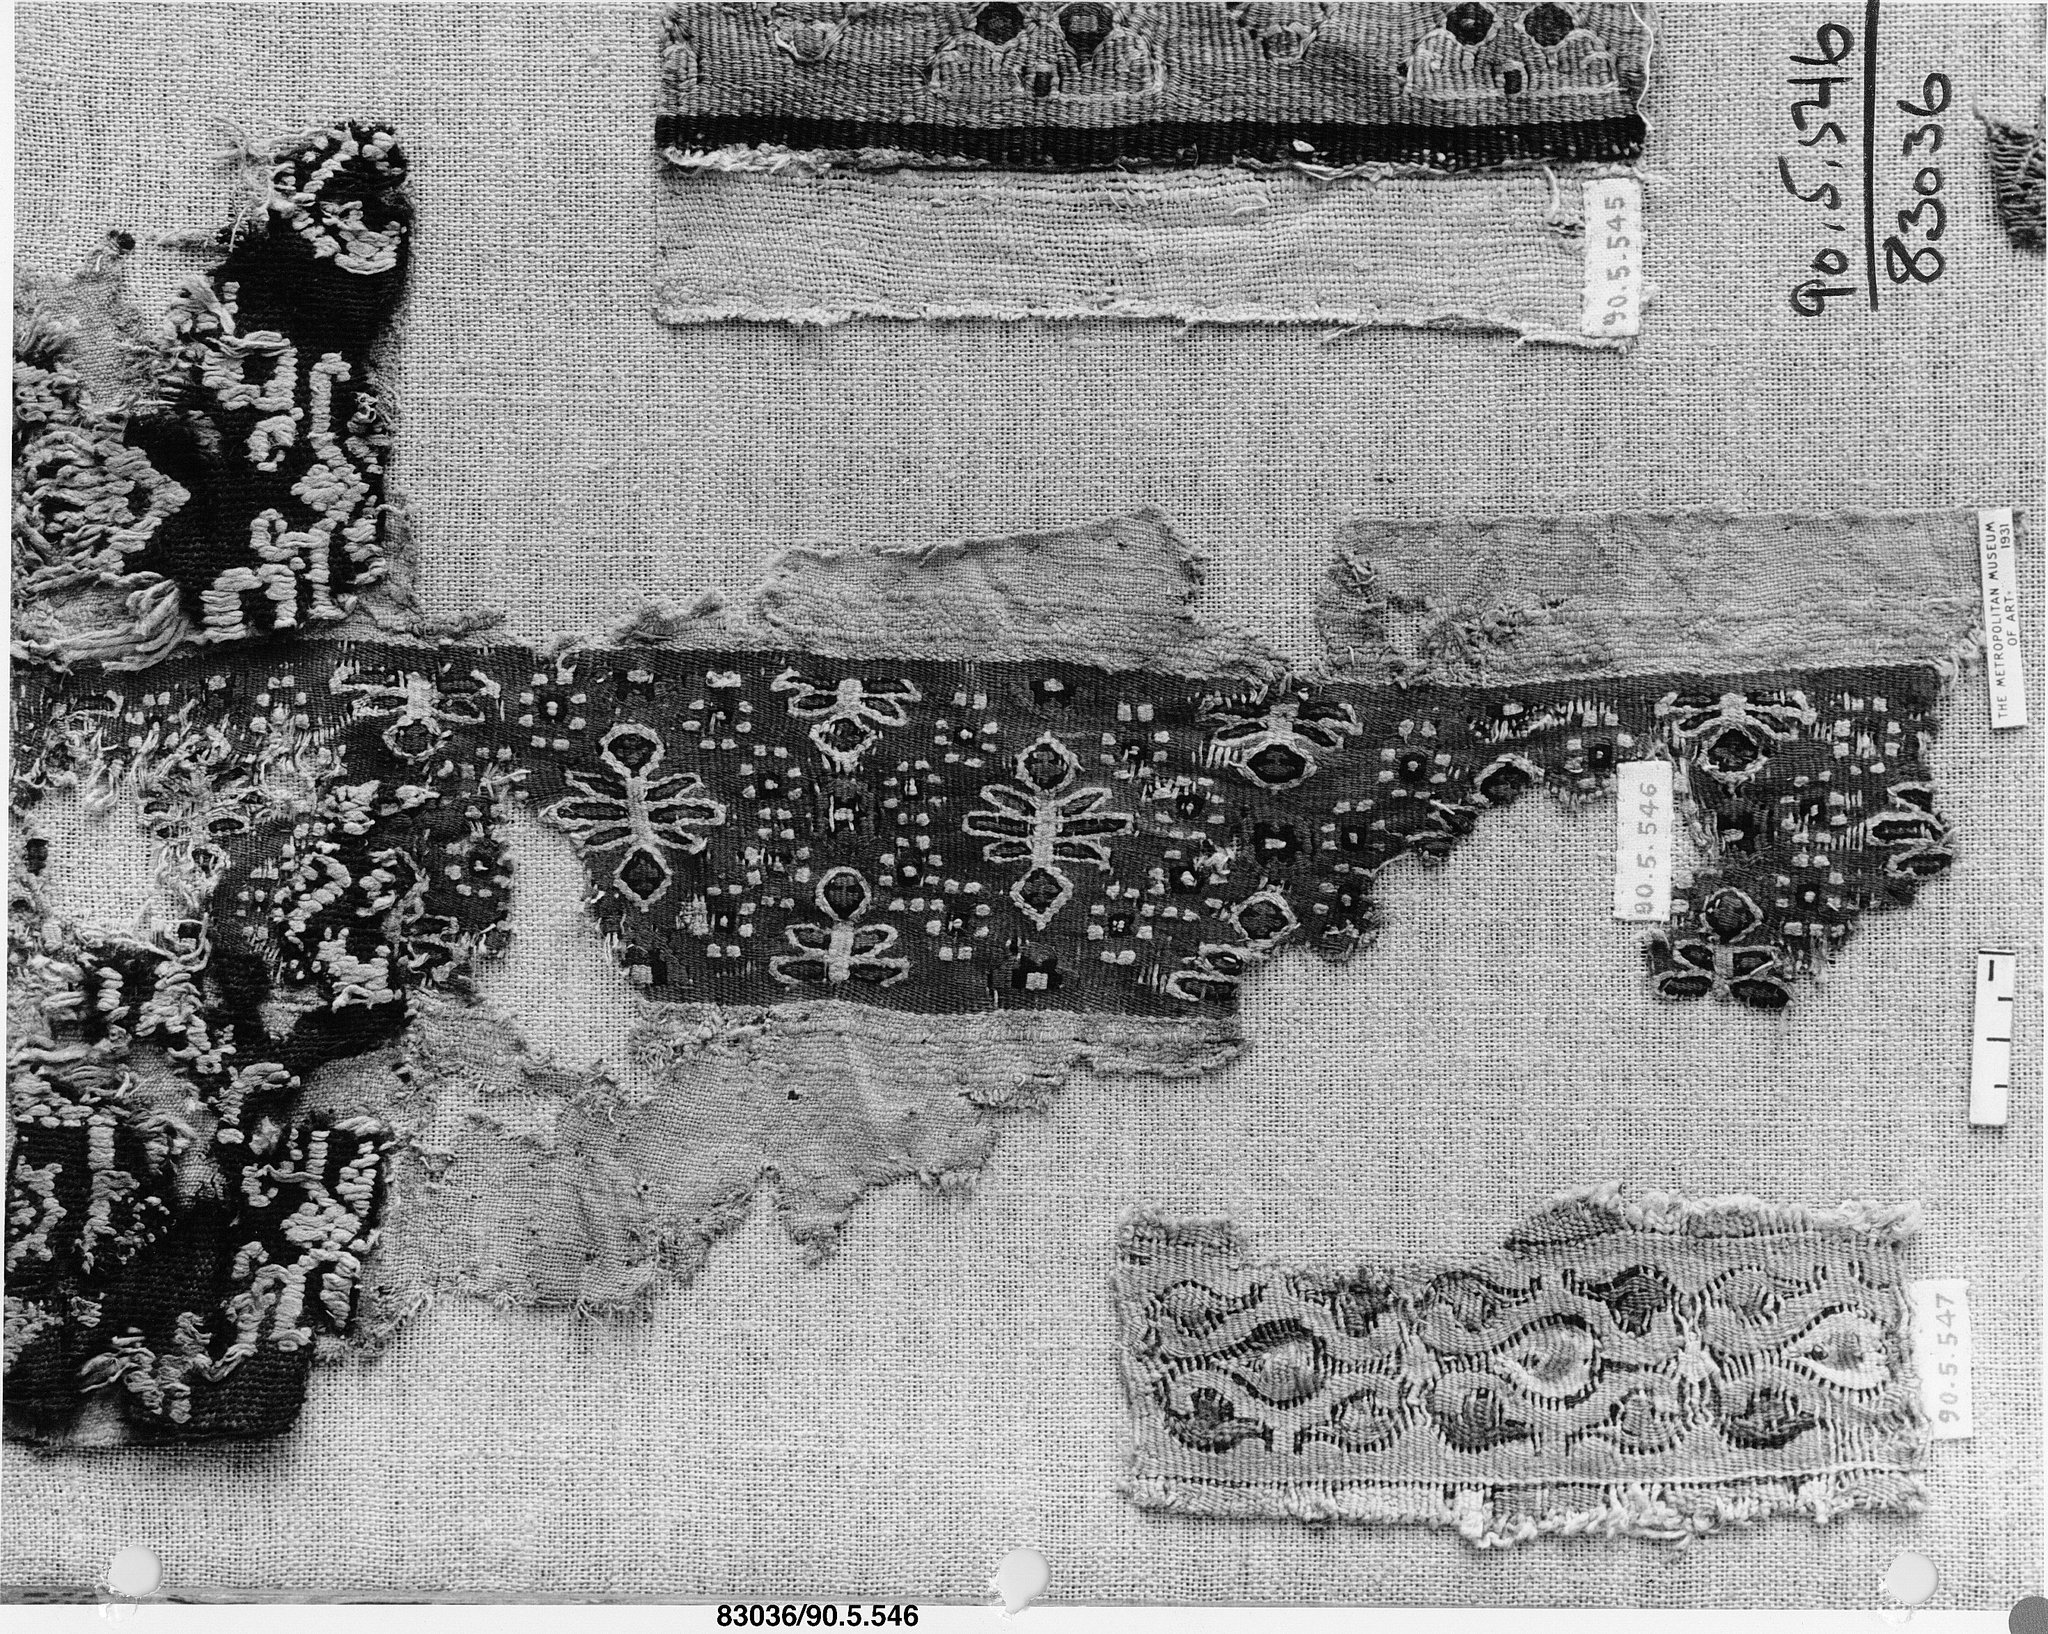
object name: textile fragment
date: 401-600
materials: linen, wool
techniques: weave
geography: egypt